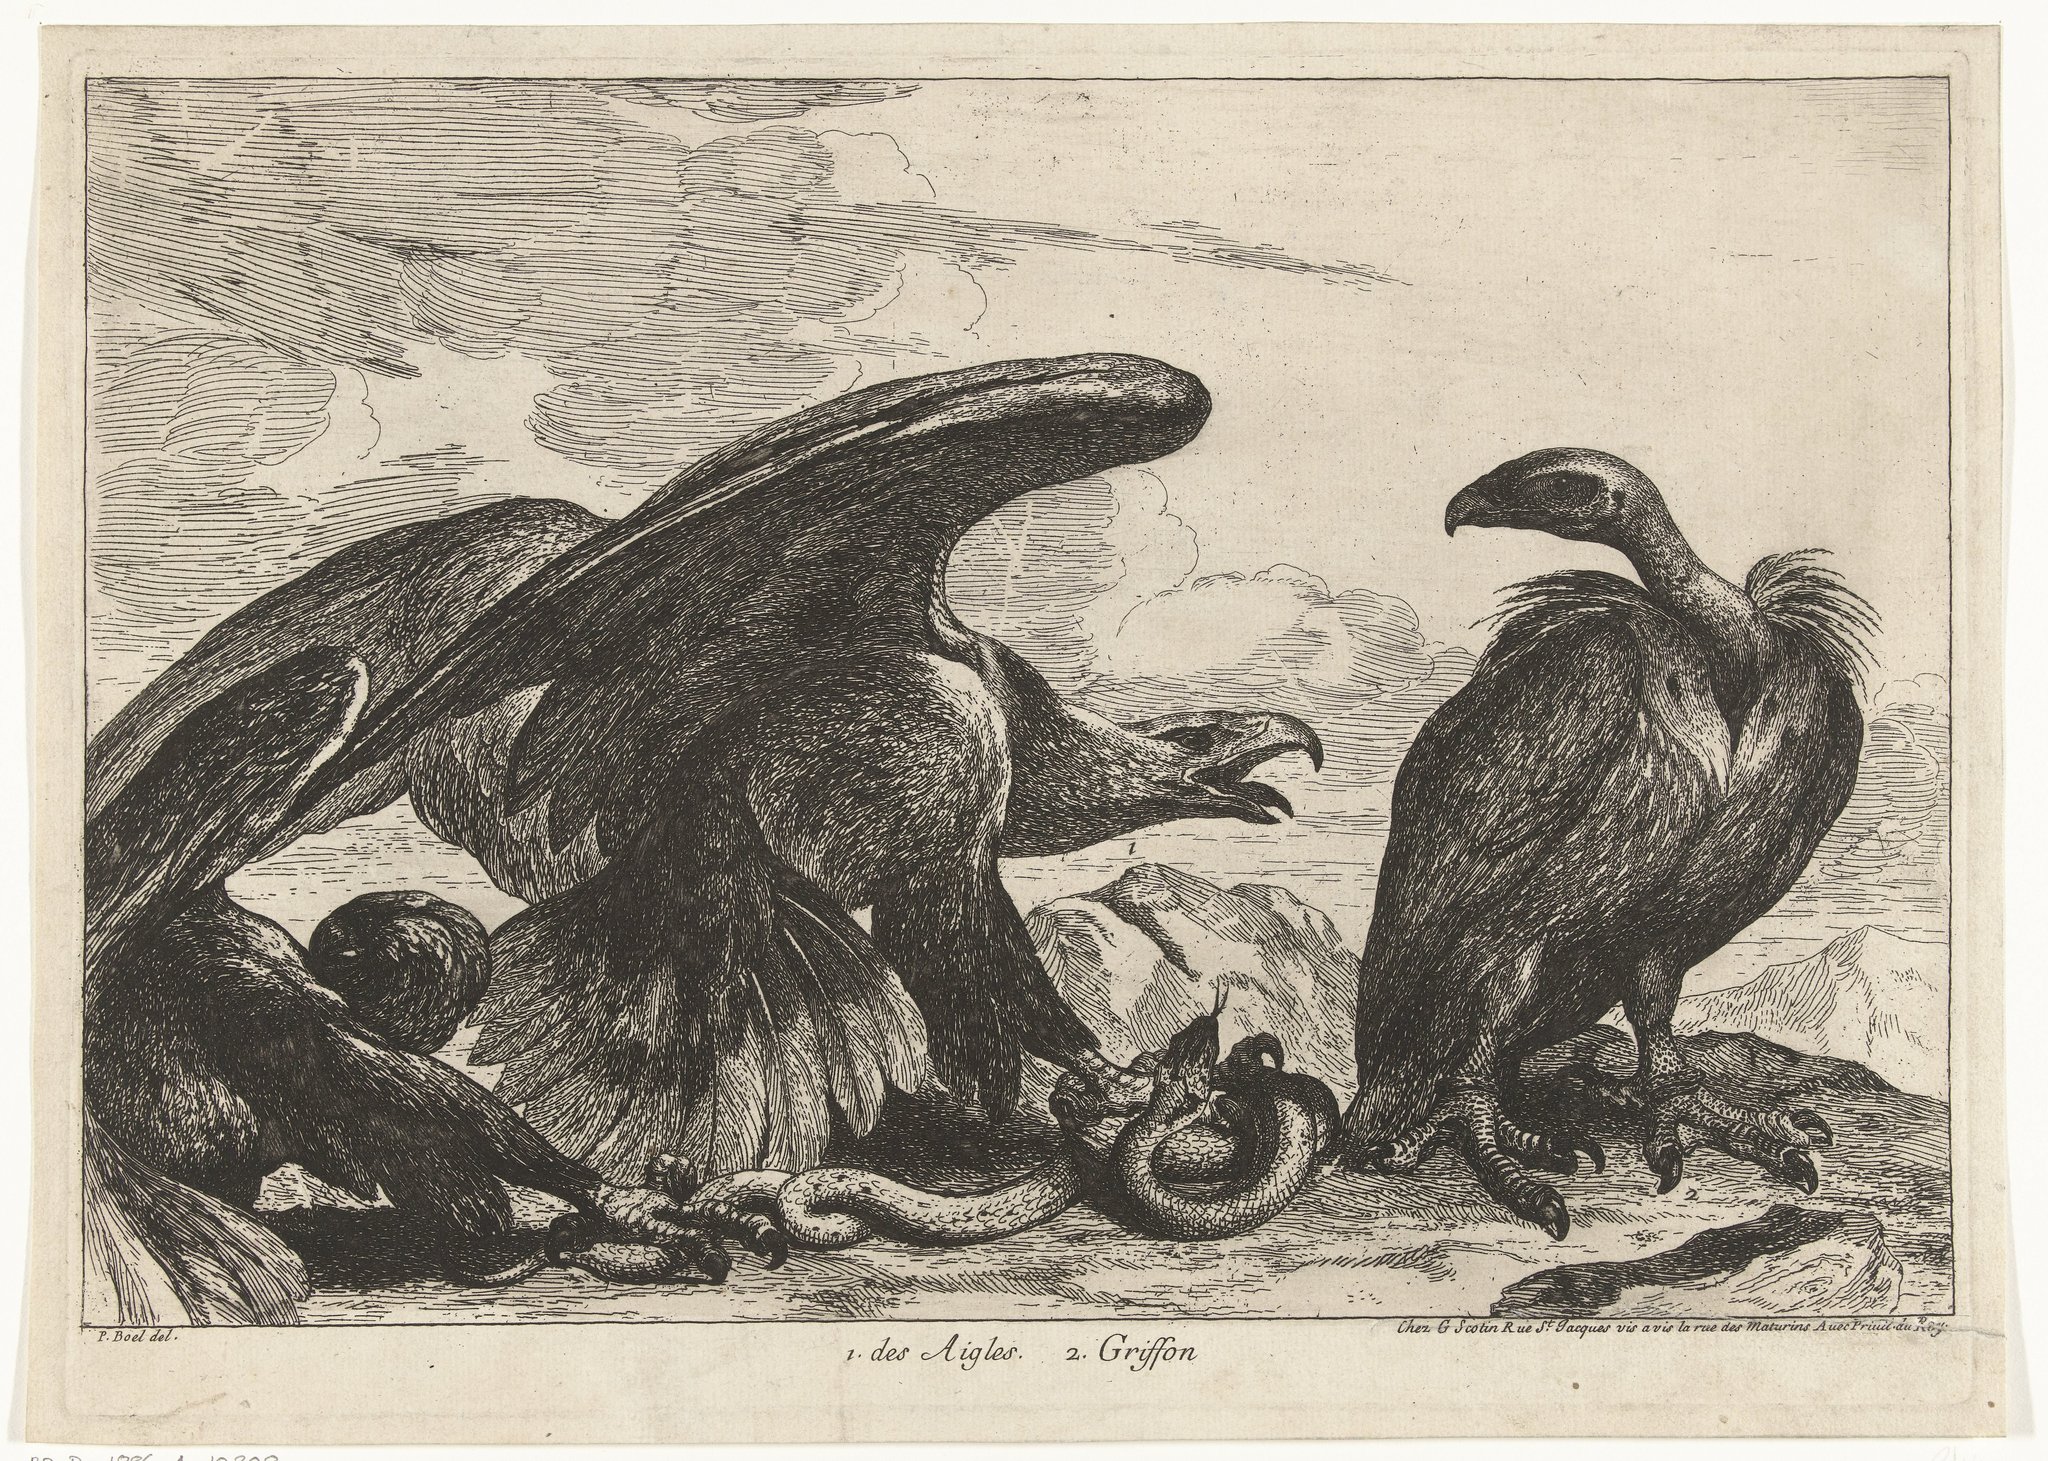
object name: print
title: Gier en een arend met slang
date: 1670-1674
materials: paper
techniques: etching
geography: paris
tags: predatory birds: eagle, predatory birds: vulture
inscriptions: collector's mark: Lugt 2228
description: In een rotsachtig landschap vechten een arend en een gier om een slang.